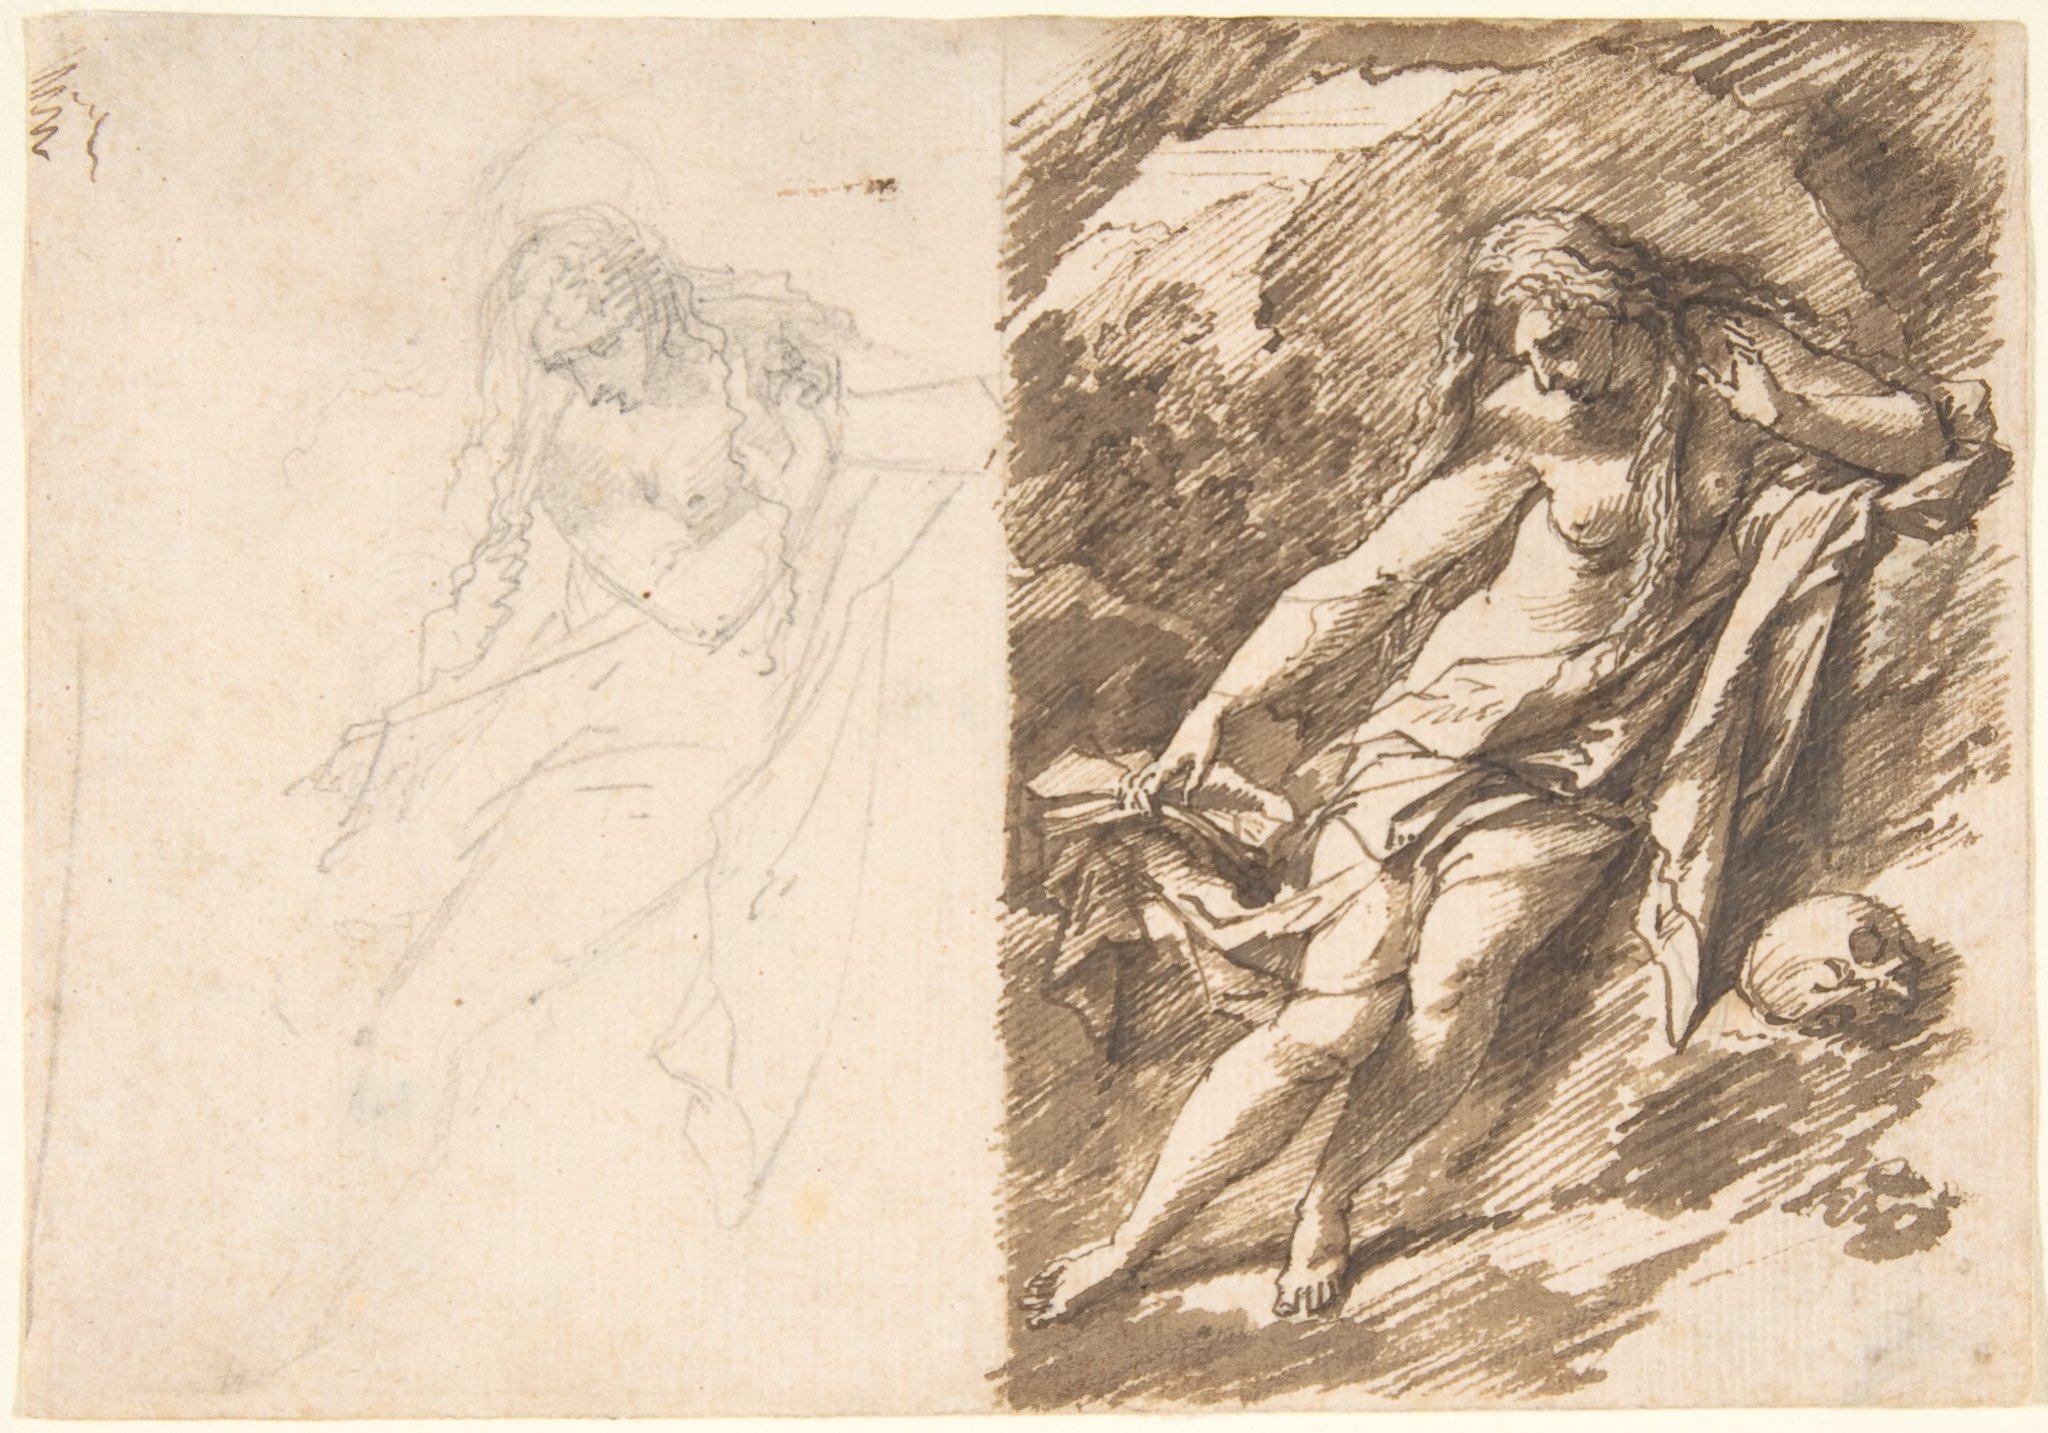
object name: drawing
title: The Penitent Magdalene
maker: adriaen van der werff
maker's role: artist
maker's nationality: dutch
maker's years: 1659-1722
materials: ink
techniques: pen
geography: netherlands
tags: mary magdalene